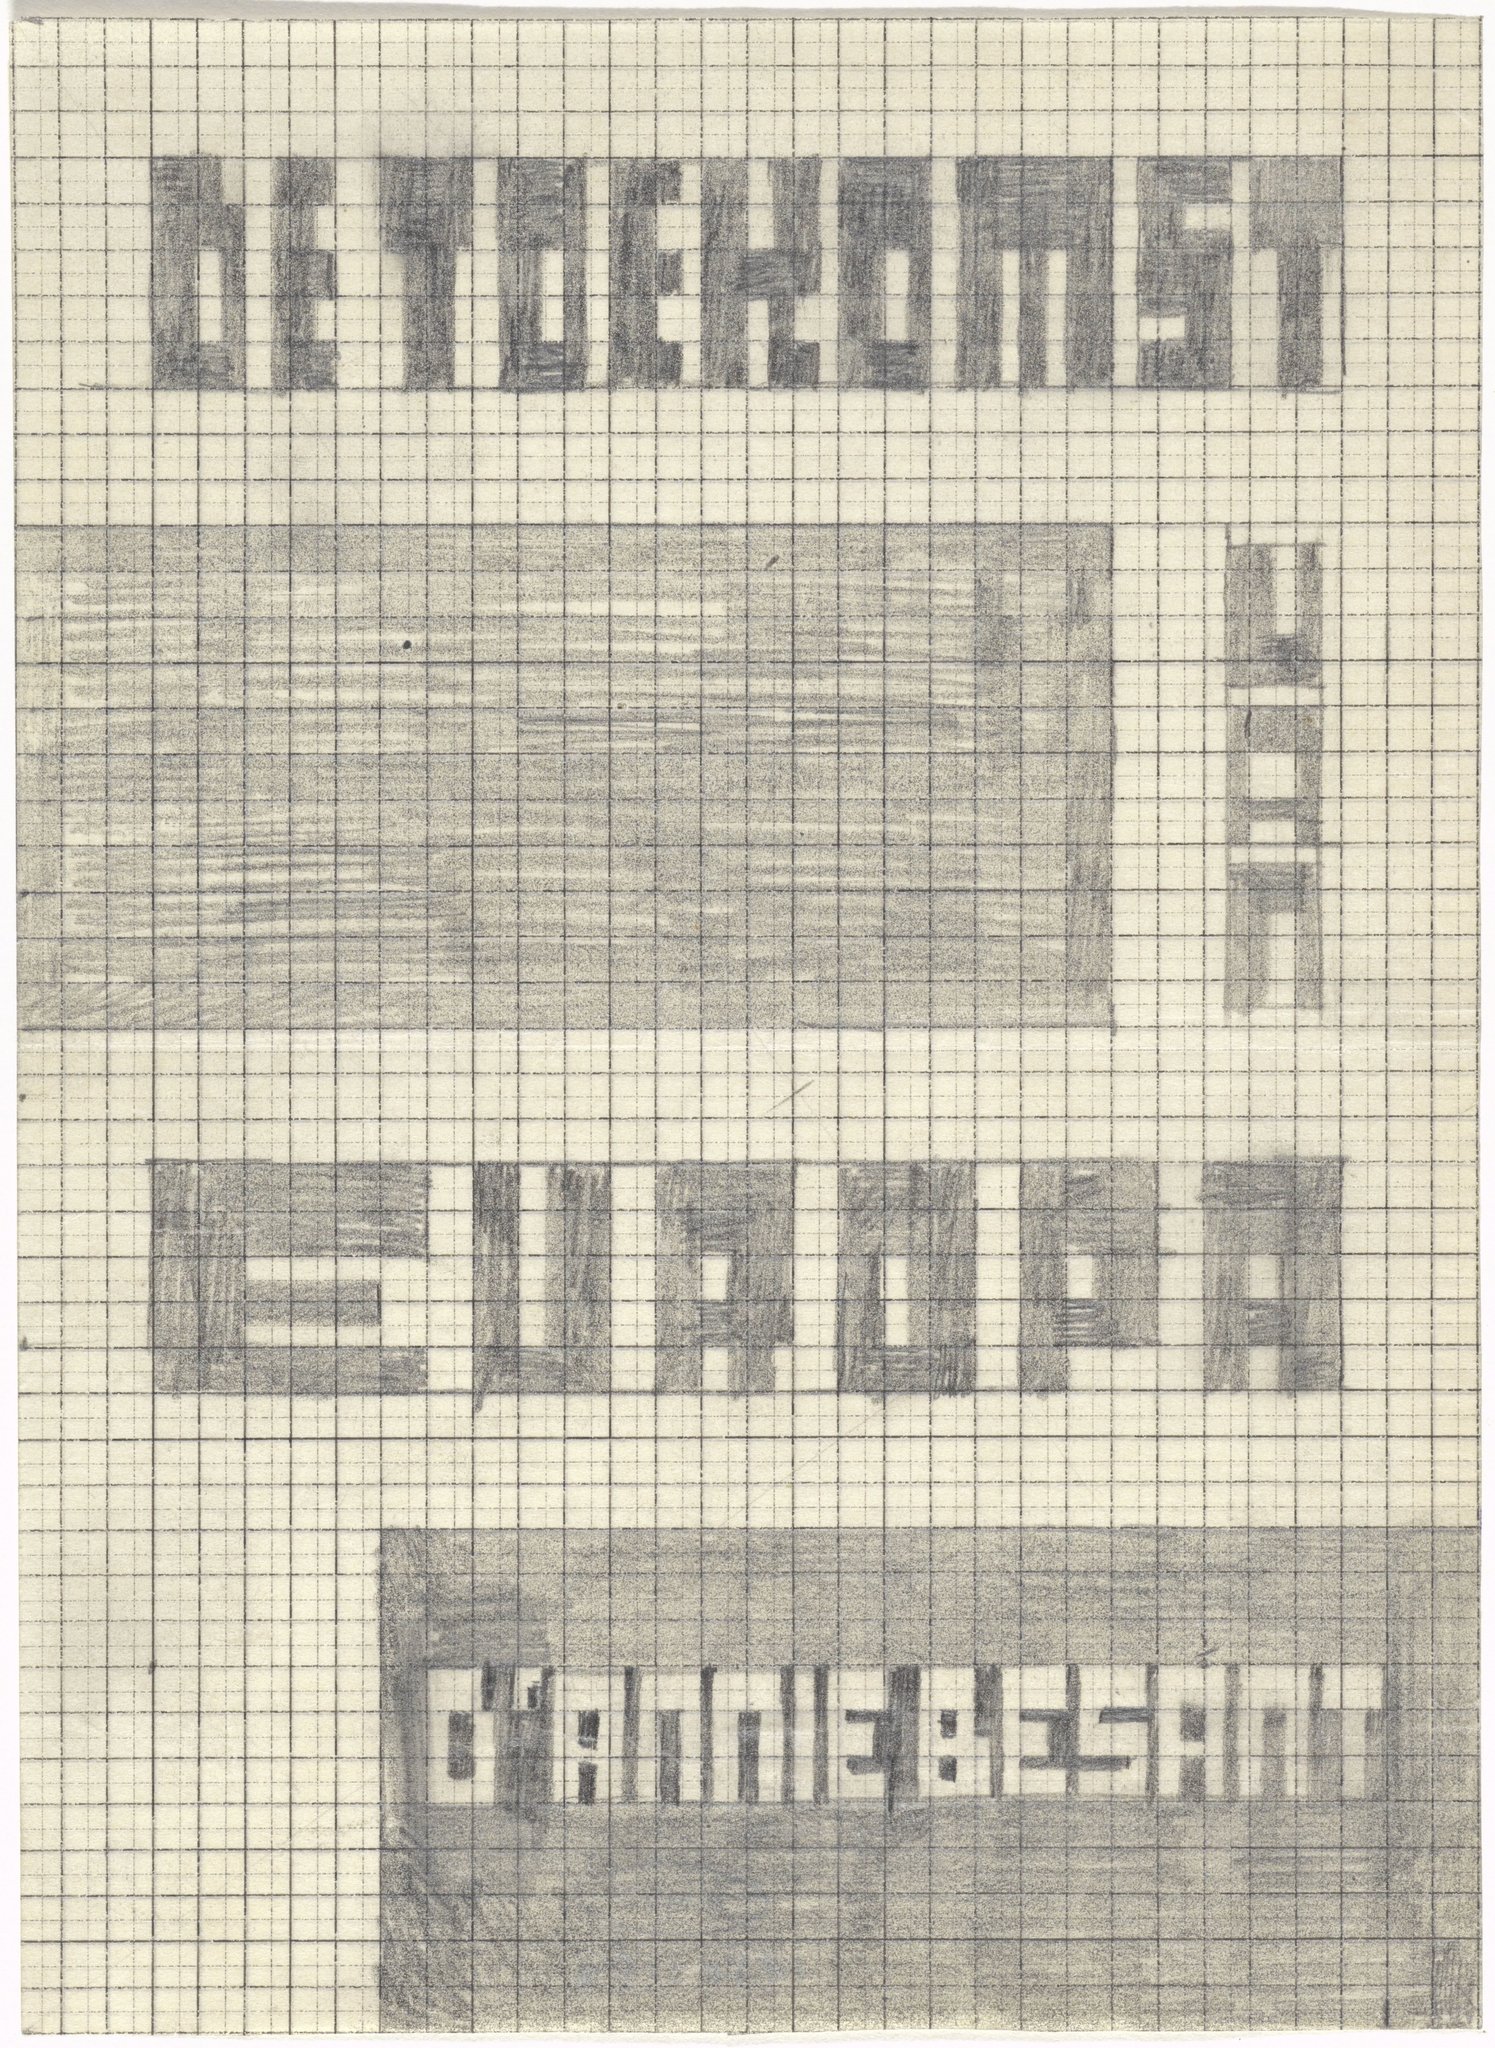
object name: design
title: Ontwerp voor de omslag van de folder De toekomst van Europa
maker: mathieu lauweriks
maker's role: designer, draughtsman, print maker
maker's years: 1864-1932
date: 1874-1932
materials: pencil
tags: weekly, monthly, magazine, etc., ornamental decoration ~ printed matter, book, book-cover, binding